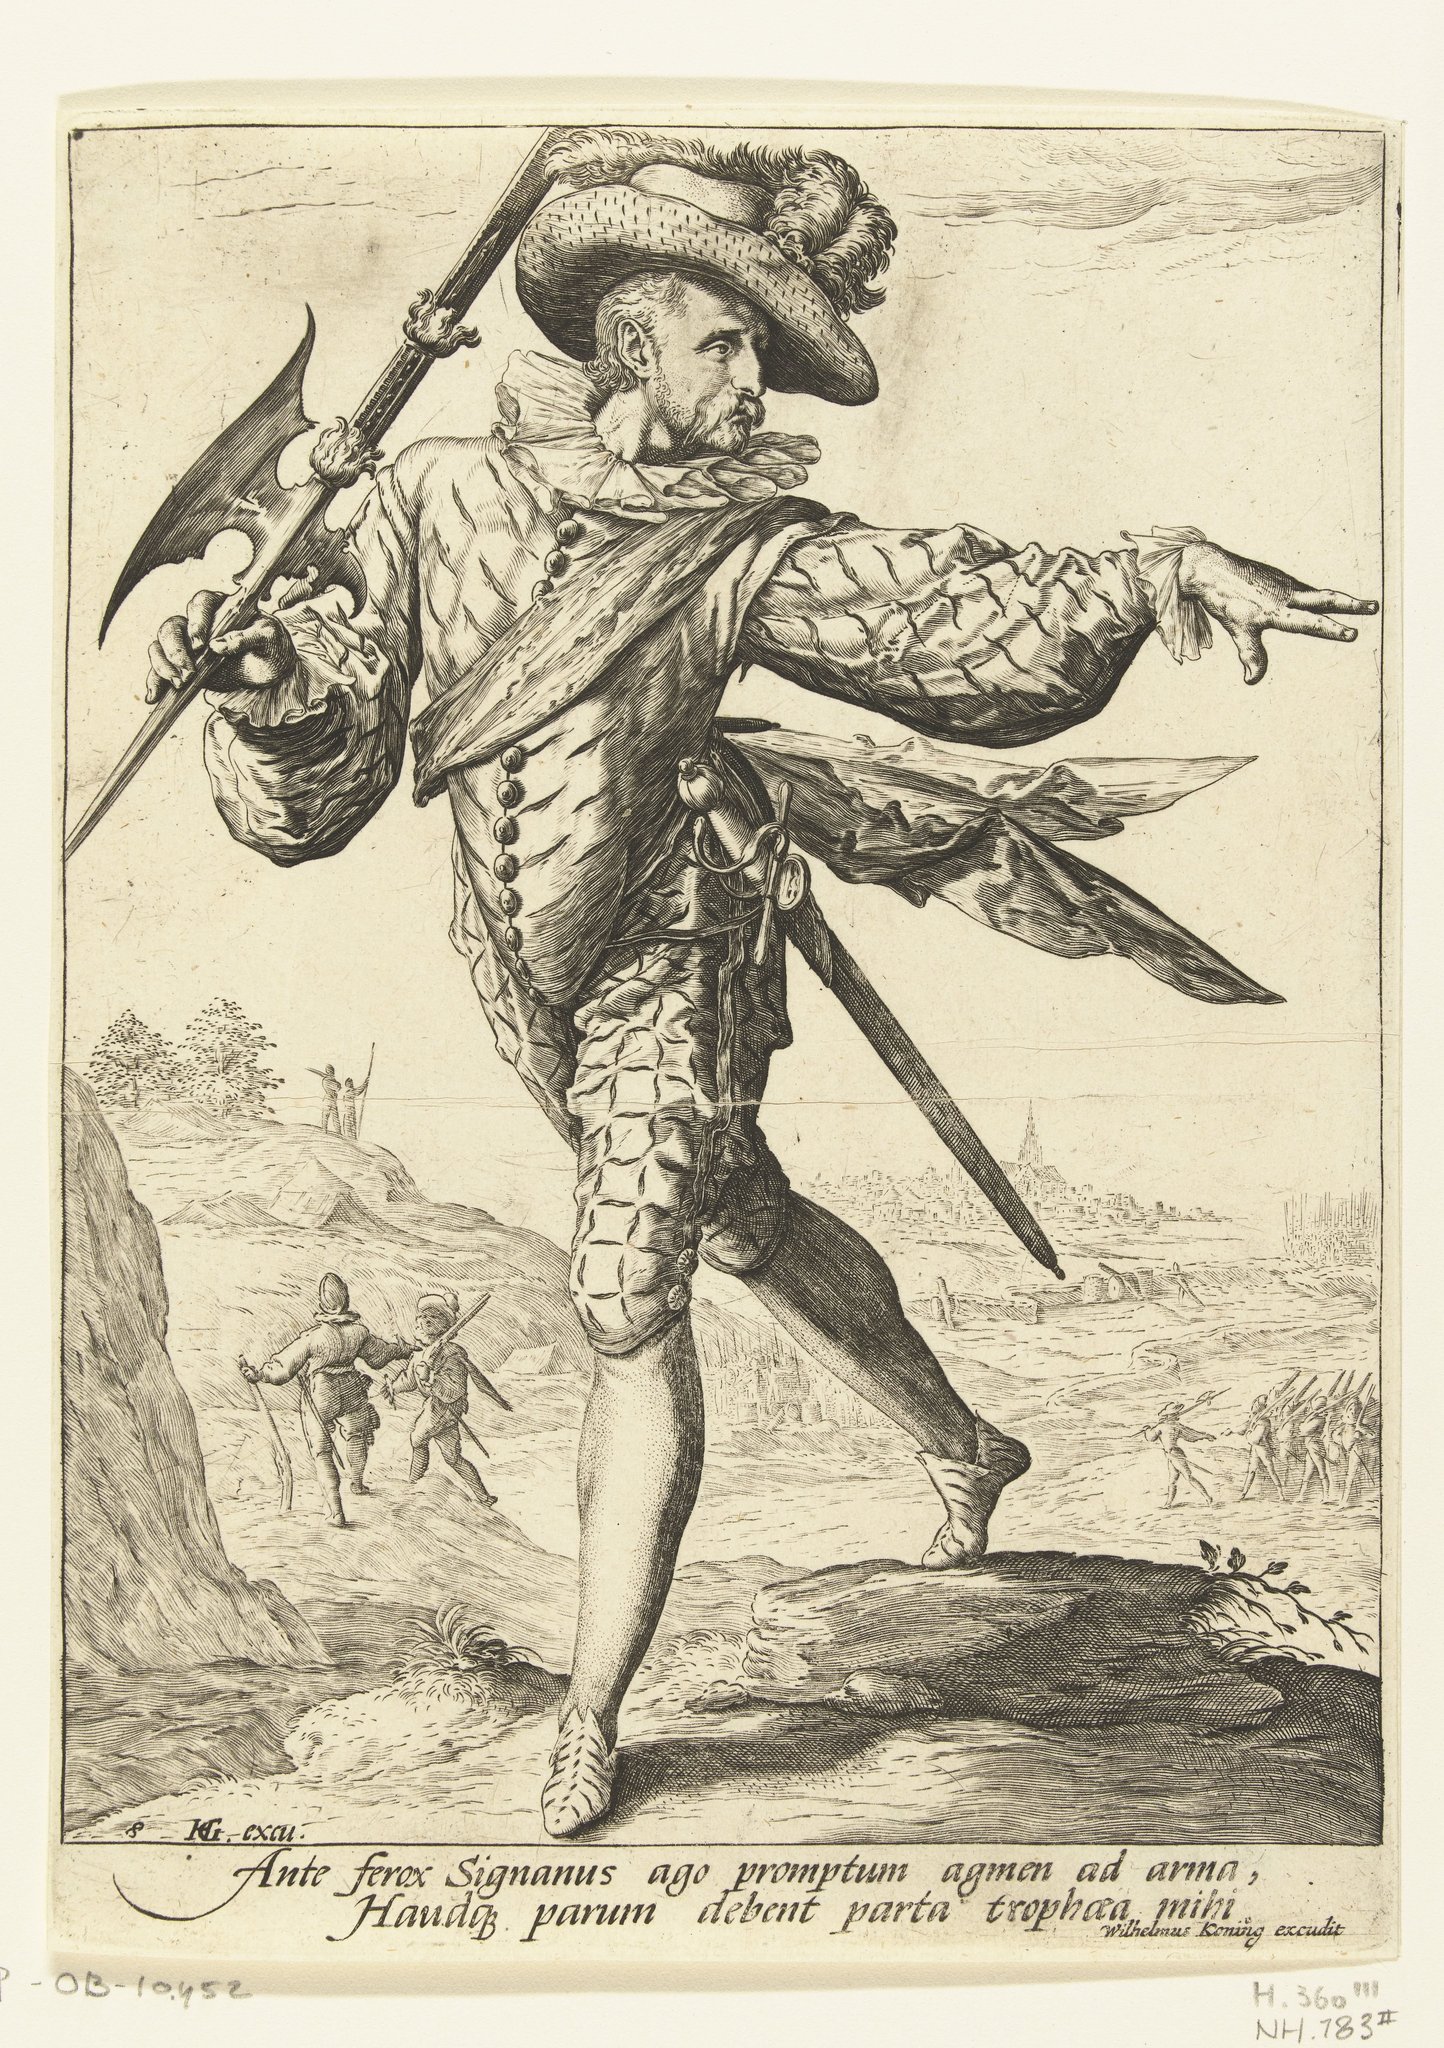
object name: print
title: Officieren en soldaten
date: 1587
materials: paper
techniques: engraving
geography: amsterdam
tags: siege, position war, helved weapons, polearms (for striking, hacking, thrusting), officer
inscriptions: collector's mark: Lugt 2228a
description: Een man in militaire uitdossing (een sergeant), ten voeten uit, op de linkerzijde gezien, een zwaard aan zijn gordel, een stokwapen (hellebaard) in zijn rechterhand. Op de achtergrond een heuvelachtig landschap waarin een belegering plaatsvindt. Onder de voorstelling twee regels tekst in Latijn. Deze prent is onderdeel van een serie van 12 genummerde prenten van militairen, ten voeten uit weergegeven tegen een landschappelijke achtergrond waarin krijgshandelingen verricht worden, en met een tweeregelig Latijns onderschrift.